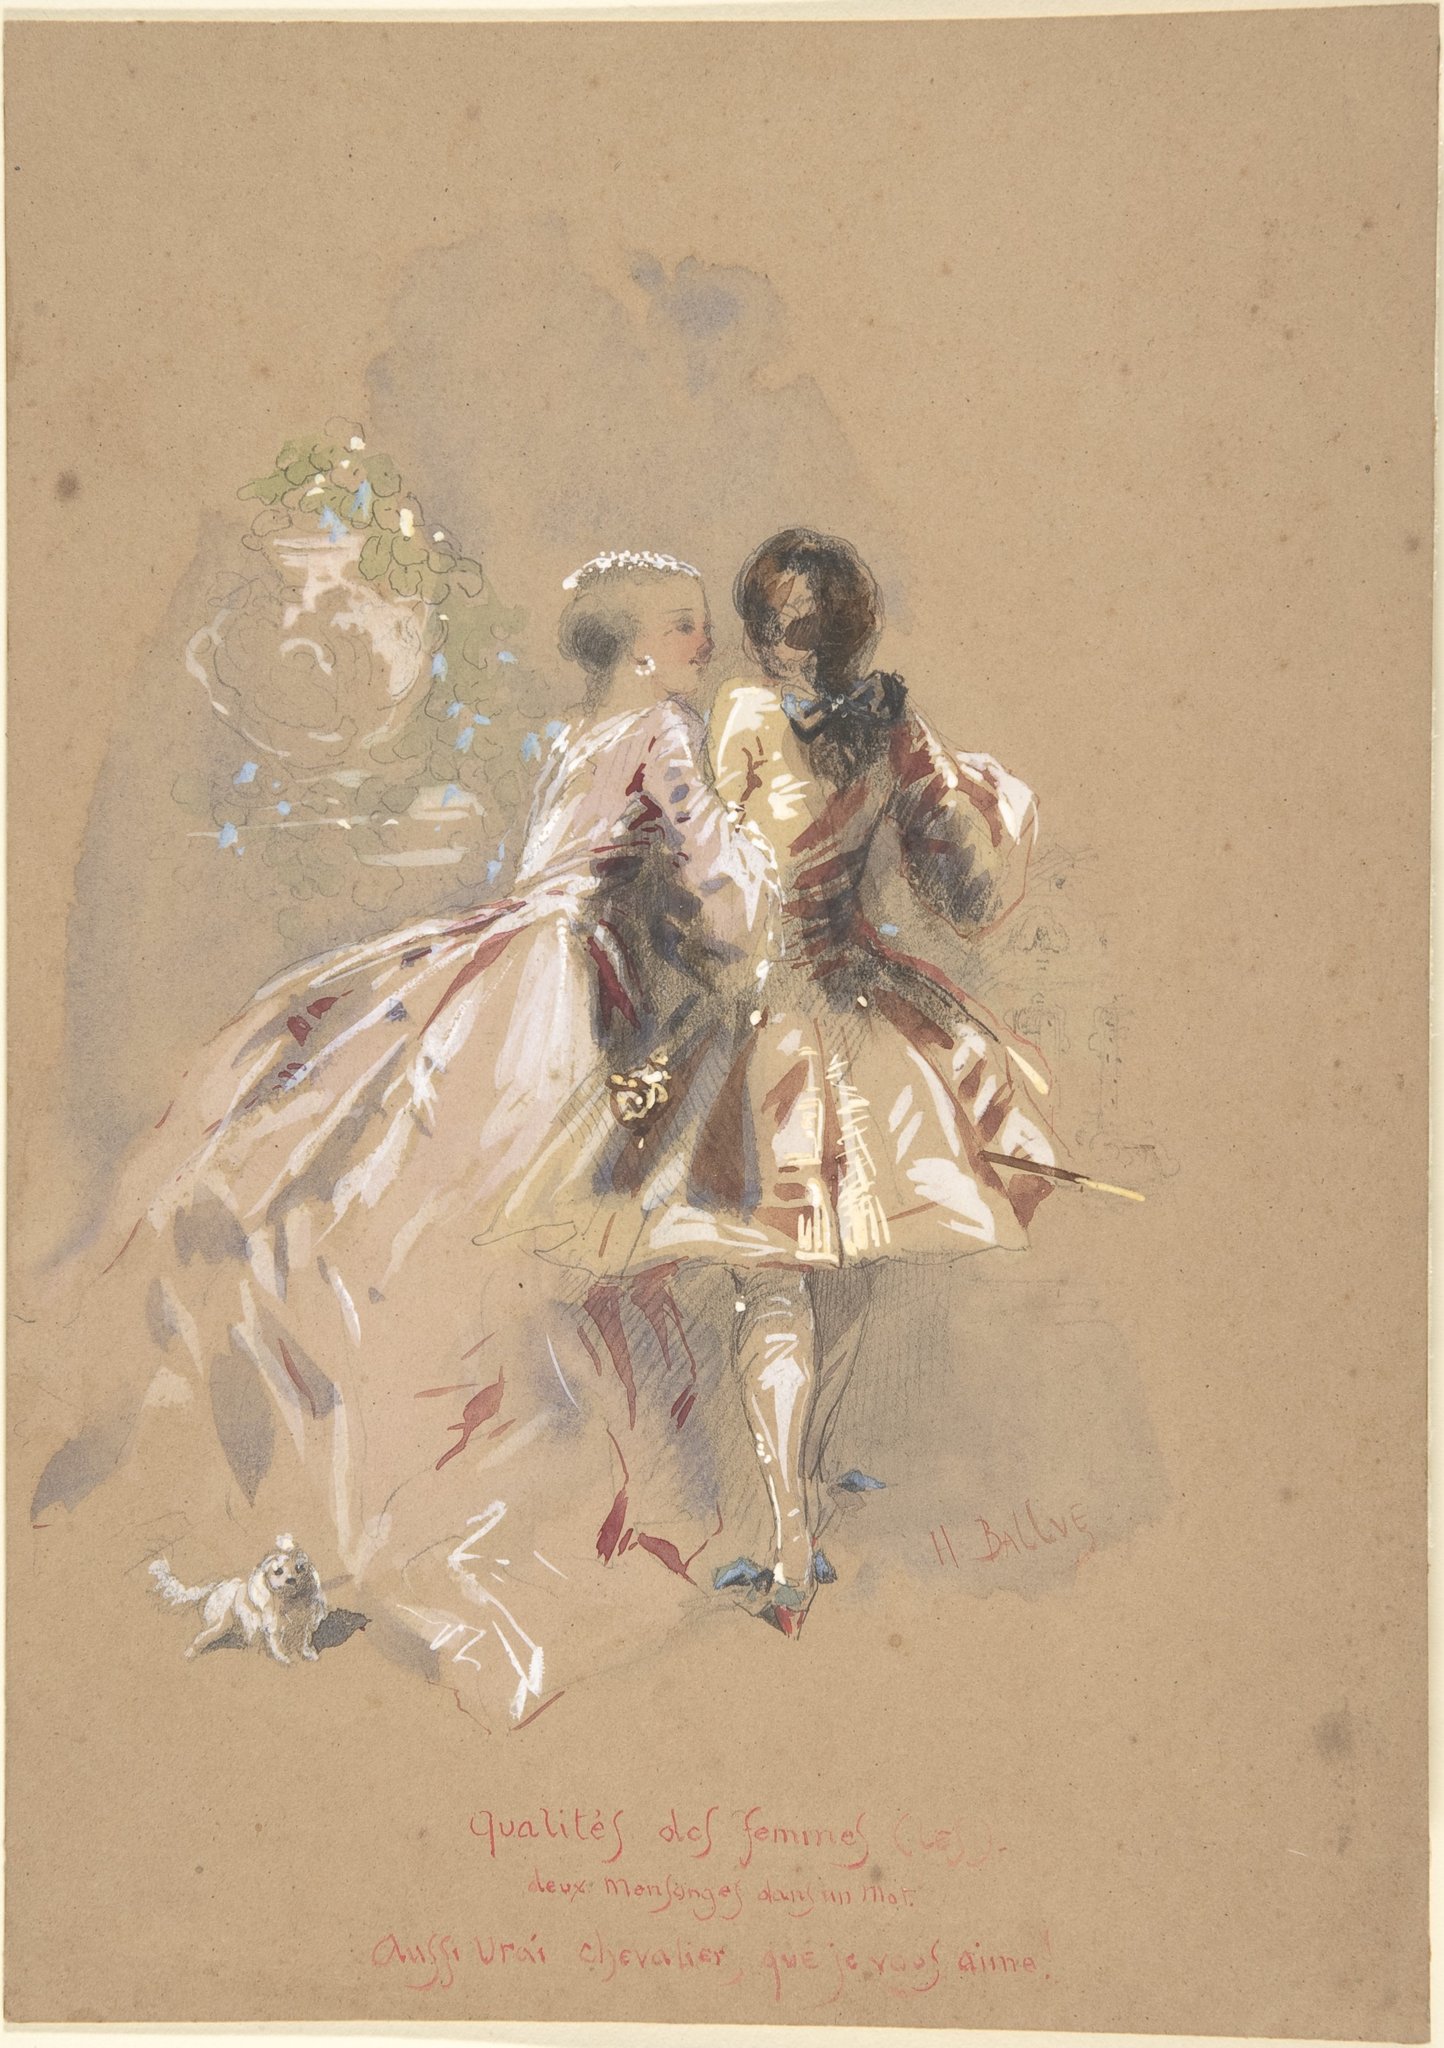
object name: drawing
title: Young Couple Seen From Behind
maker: hippolyte-omer ballue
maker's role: artist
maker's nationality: french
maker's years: 1820-1867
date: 1834-1866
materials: graphite, watercolor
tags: animals,couples,men,women